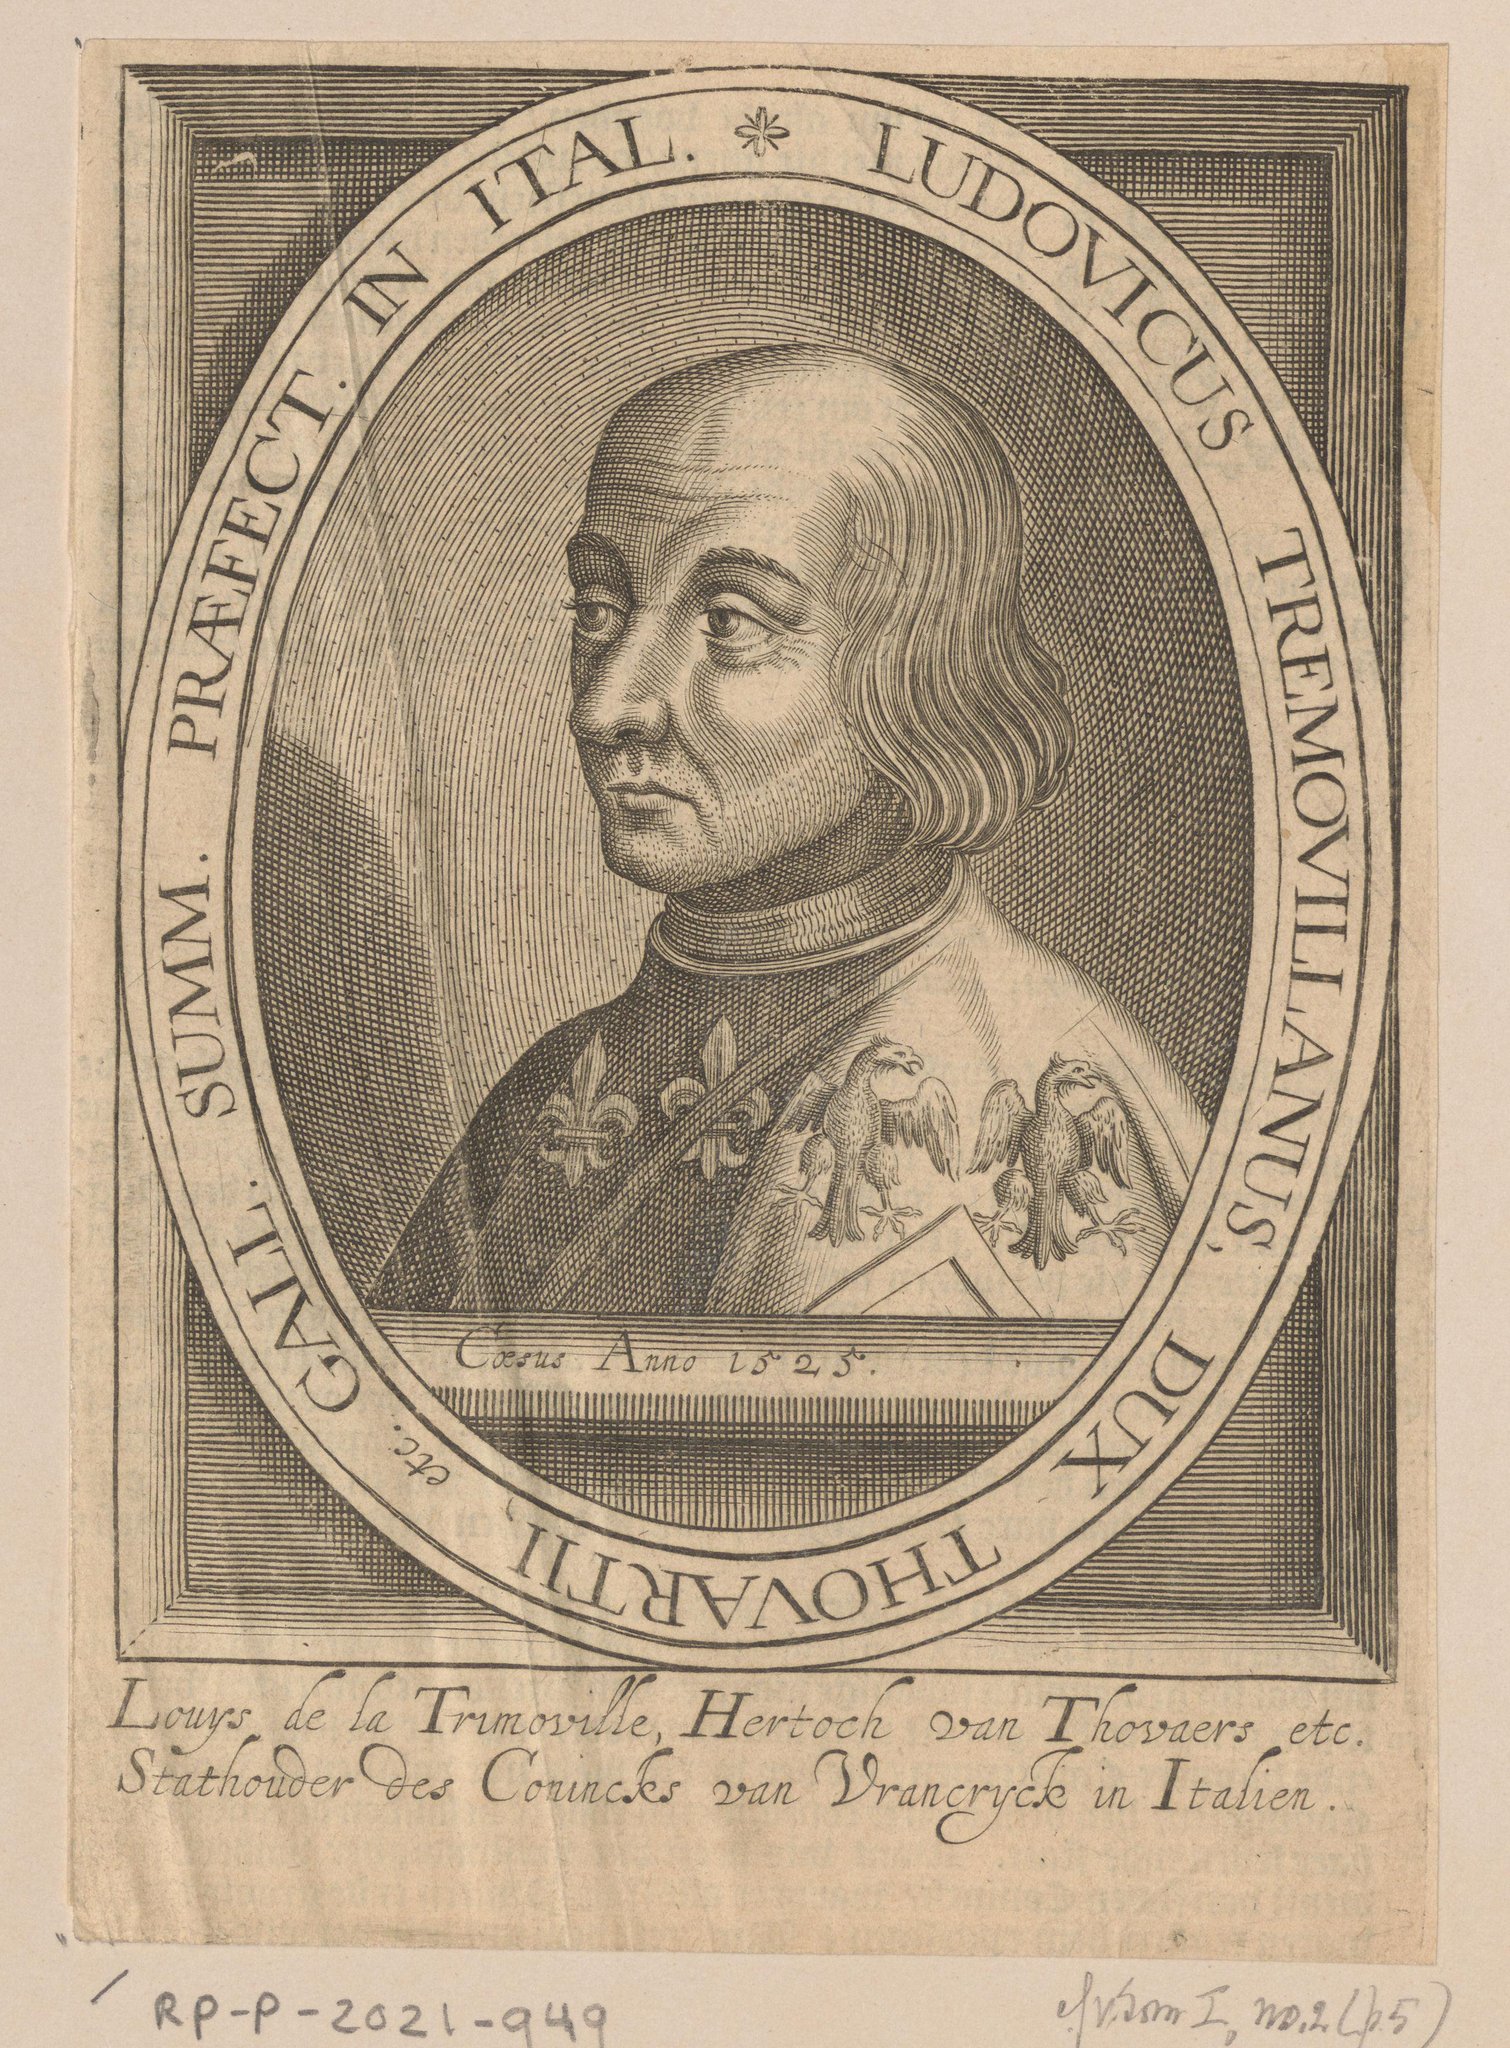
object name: print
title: Portret van Lodewijk II de la Trémoille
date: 1617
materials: paper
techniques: engraving, letterpress printing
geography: delft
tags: historical persons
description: Prent uit: Tooneel der beroemder hertogen princen graven ende krygs-helden van christenrijck binnen deze drij laetste eeuwen. Delft: Nicolaes de Clerck, 1617, p. 569.